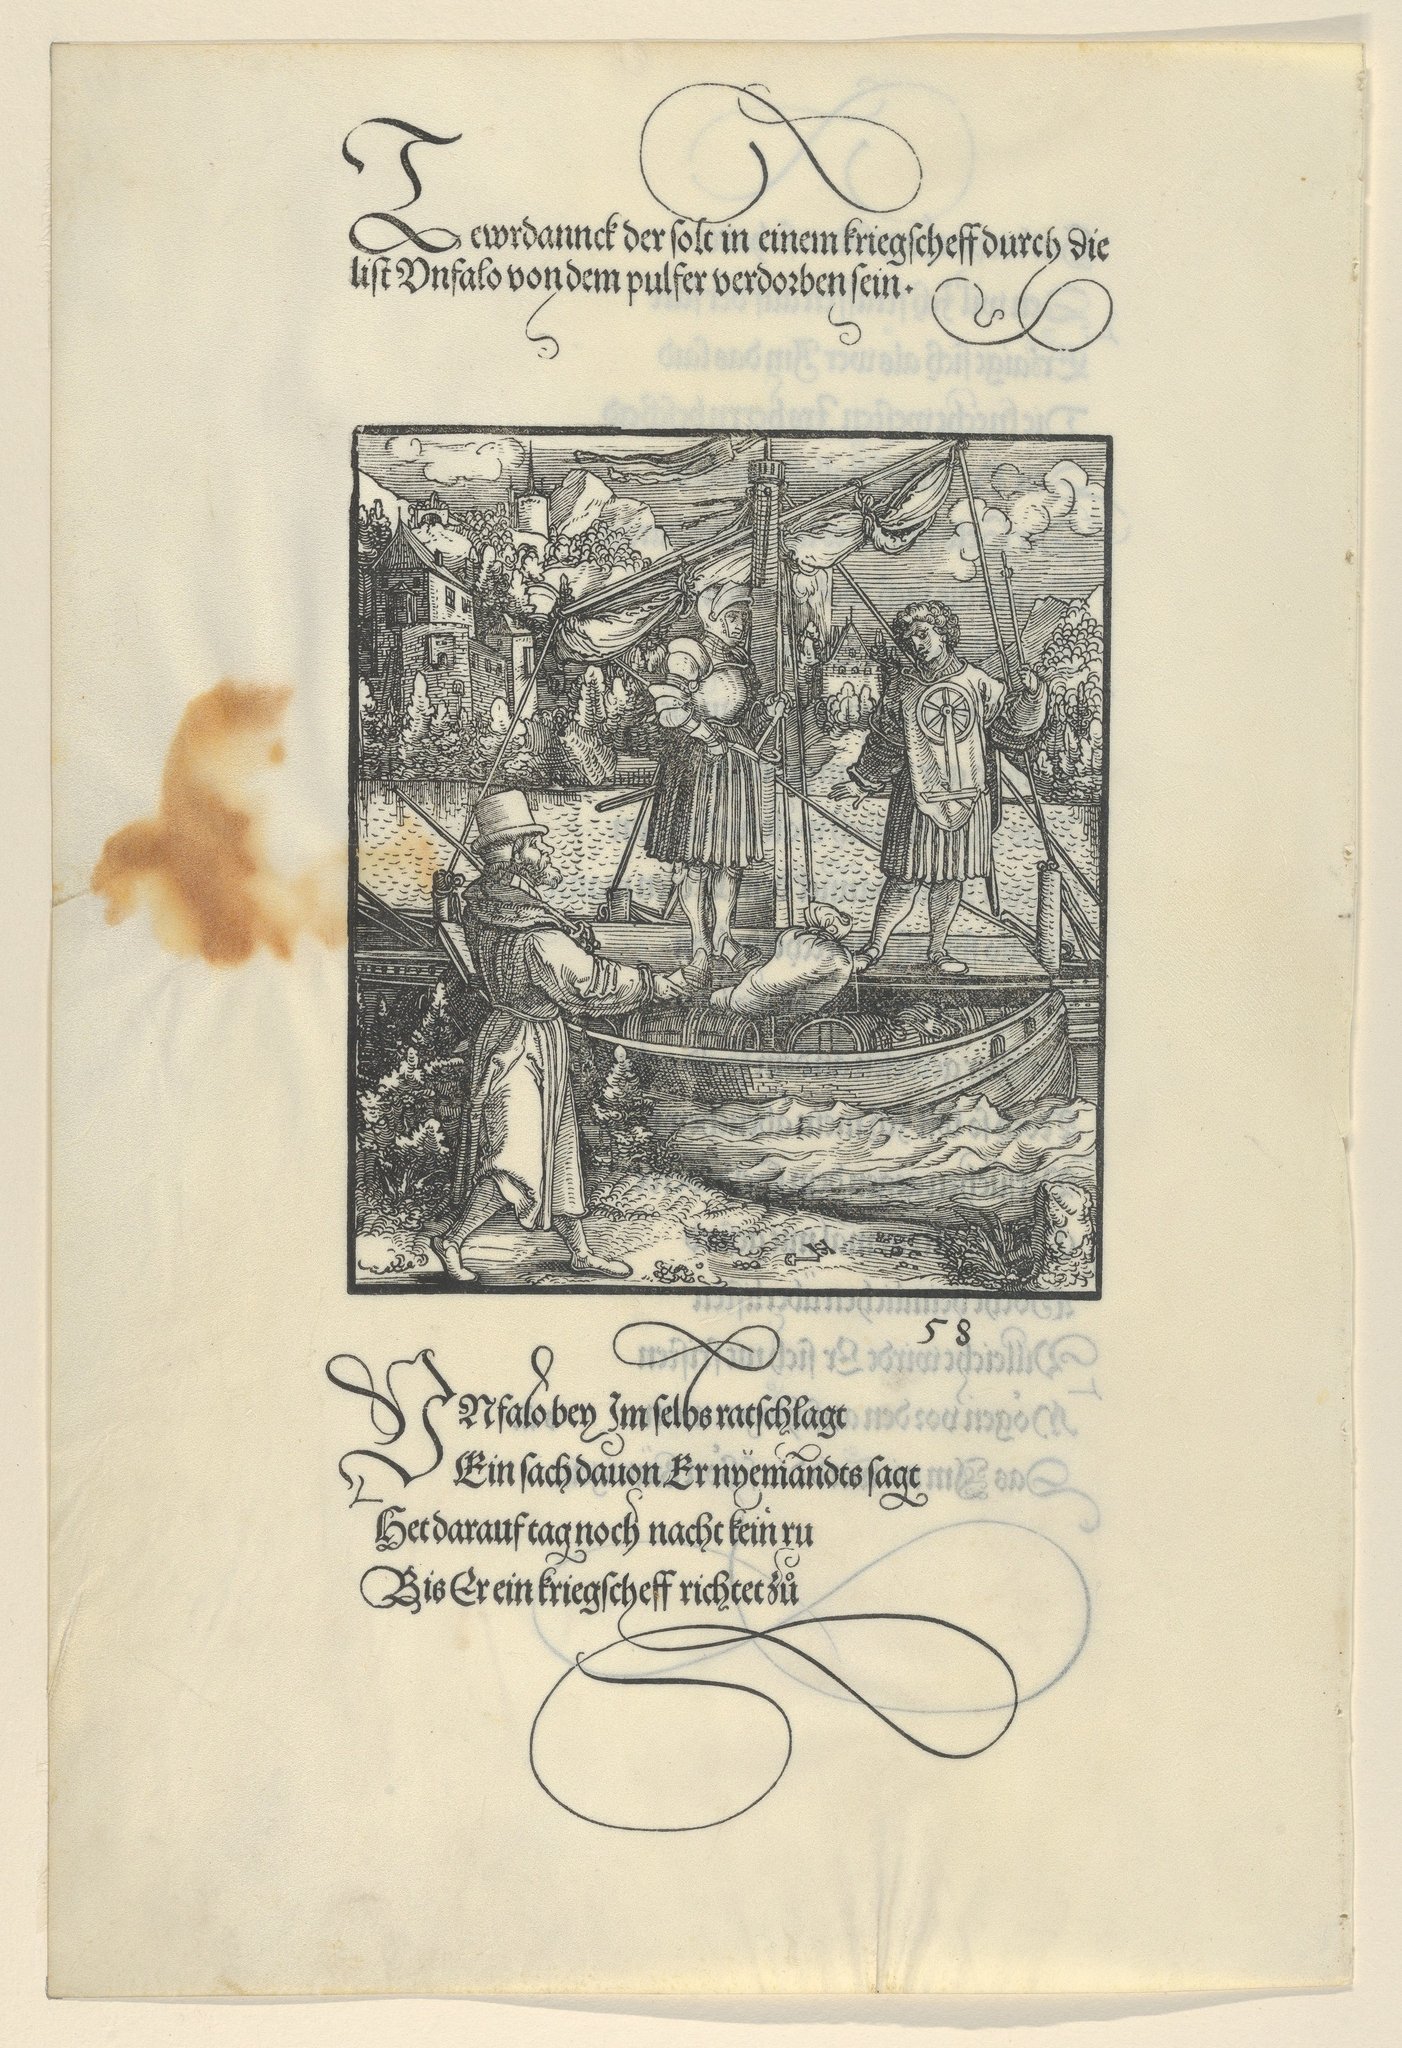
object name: print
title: Unfalo Nearly Causing the Explosion of Theuerdanck's Ship, from Theuerdanck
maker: hans schäufelein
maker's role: artist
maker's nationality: german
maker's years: 1480-1540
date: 1517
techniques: woodcut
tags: men,women,boats